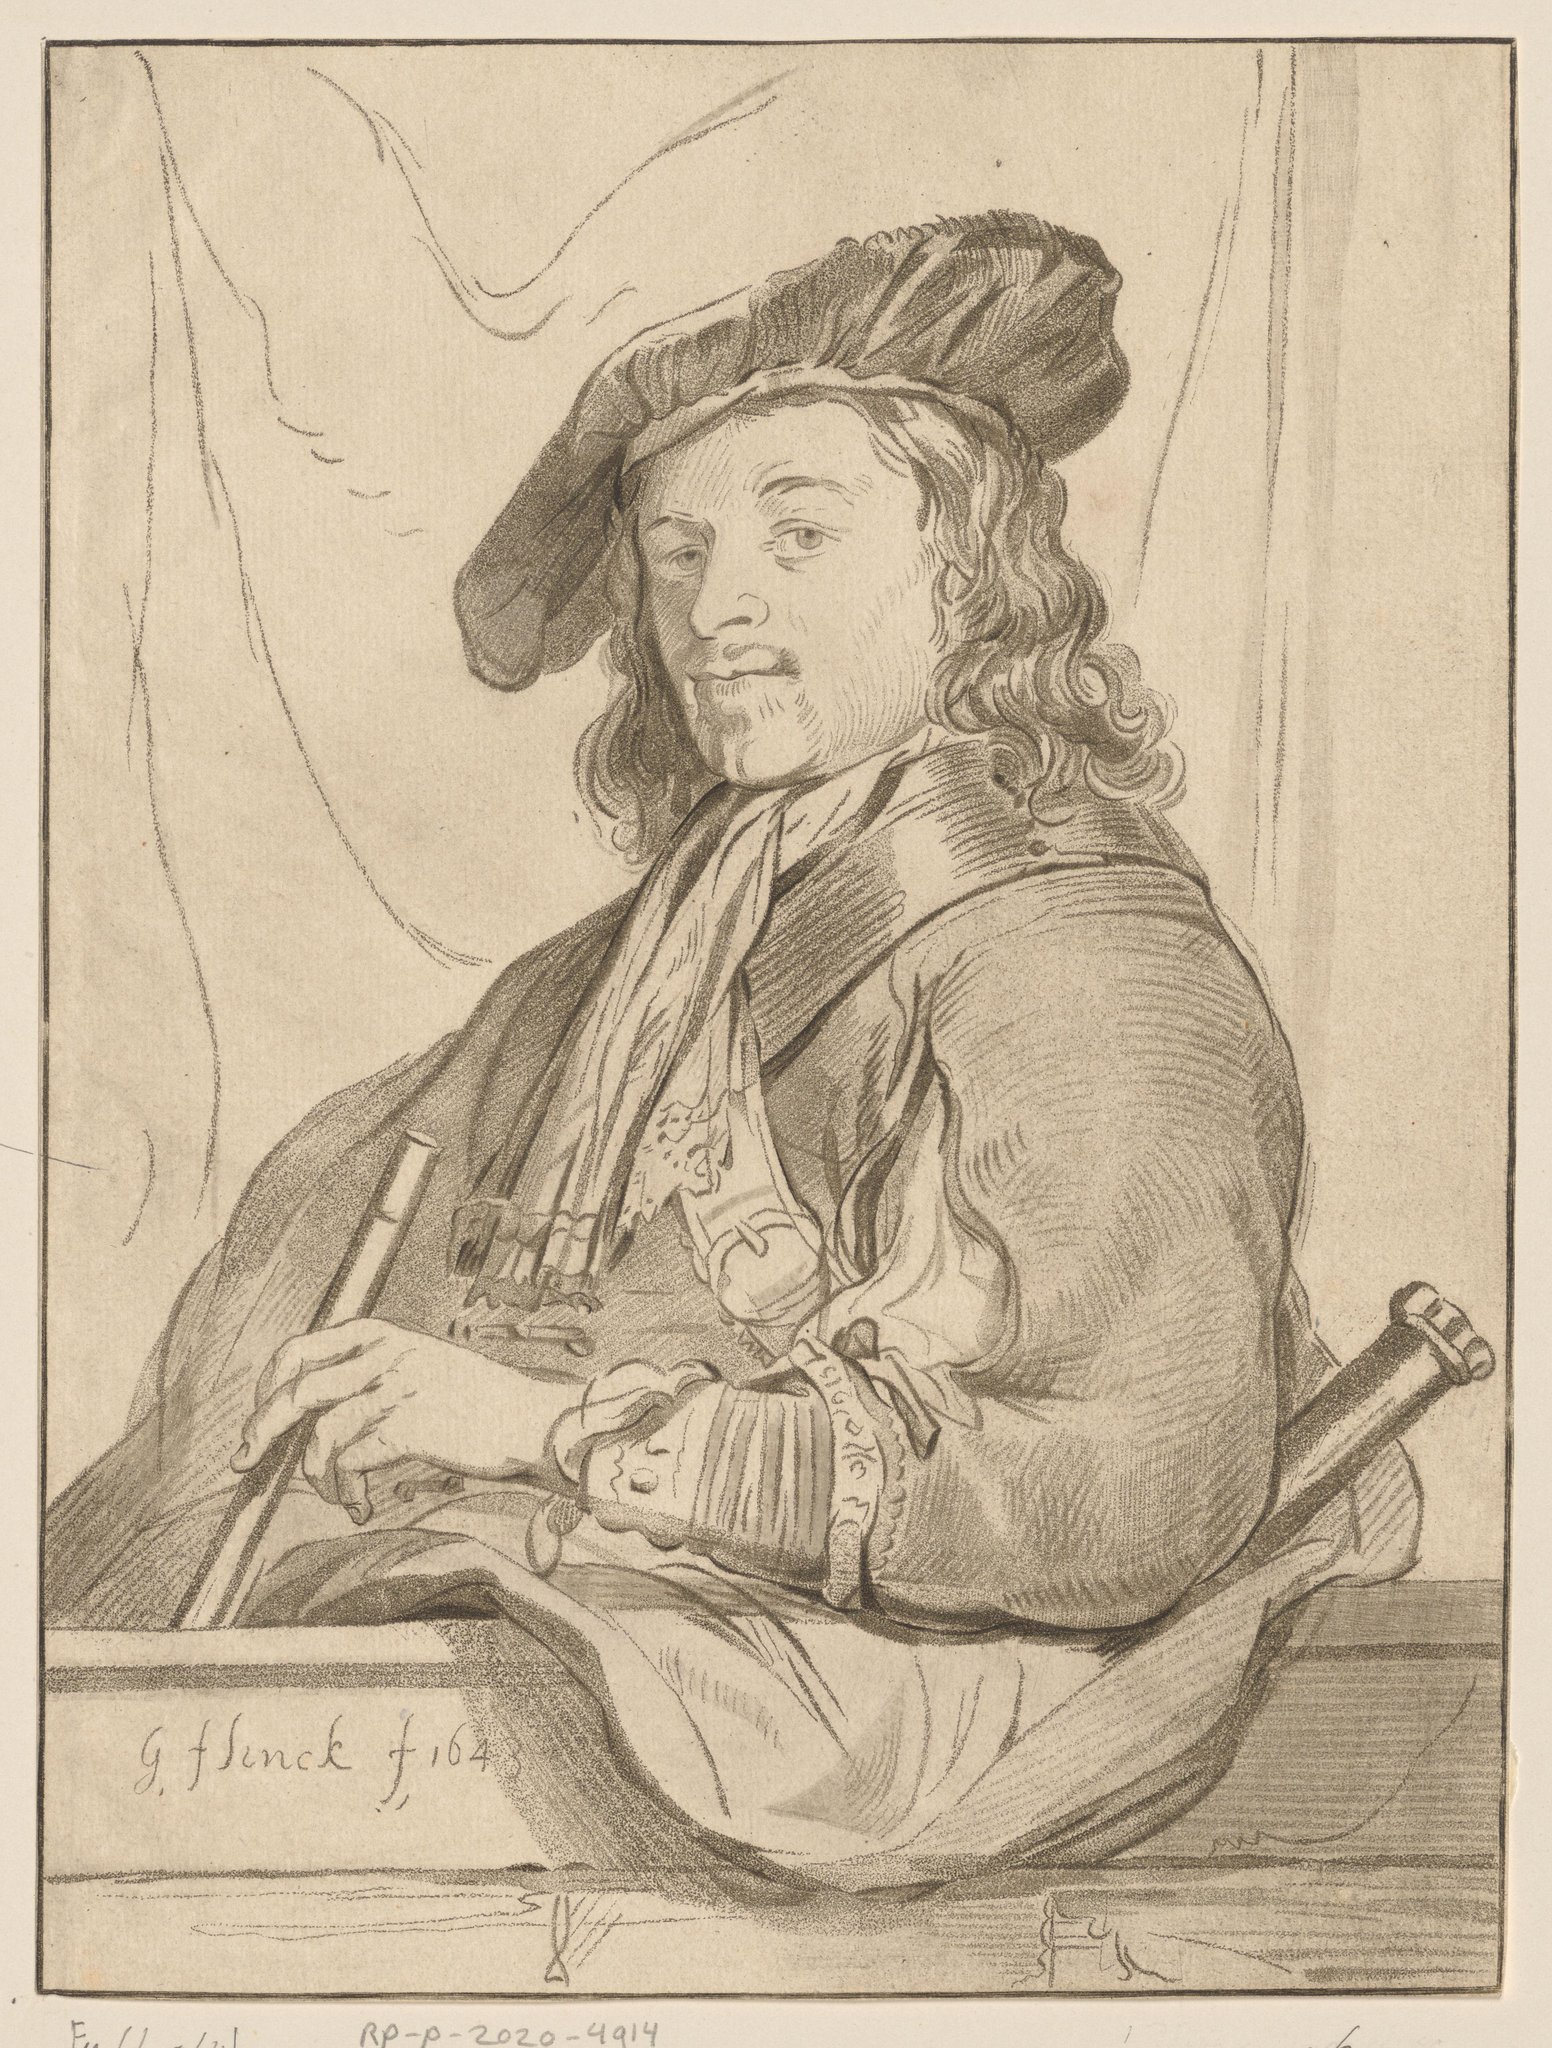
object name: print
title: Ectypa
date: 1773-1774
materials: paper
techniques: printmaking, roulette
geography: amsterdam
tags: head-gear: cap (+ men's clothes), anonymous historical person portrayed, binoculars, spy-glass, etc.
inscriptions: inscription: ‘Govt. Flinck. del. 1643. Ploos van Amstel. J.C. Fecit 1773.’, inscription: ‘Feb. 90’, collector's mark: Lugt 2725, collector's mark: Lugt 964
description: De prent maakt onderdeel uit van een serie facsimiles, uitgegeven tussen 1765 en 1787. Ploos van Amstel werkte met verschillende prentmakers om dit project te realiseren, waaronder Bernard Schreuder, Cornelis Brouwer, Johannes Körnlein, Jacobus Buys, Jurriaan Cootwijck en Christian Dietrich.